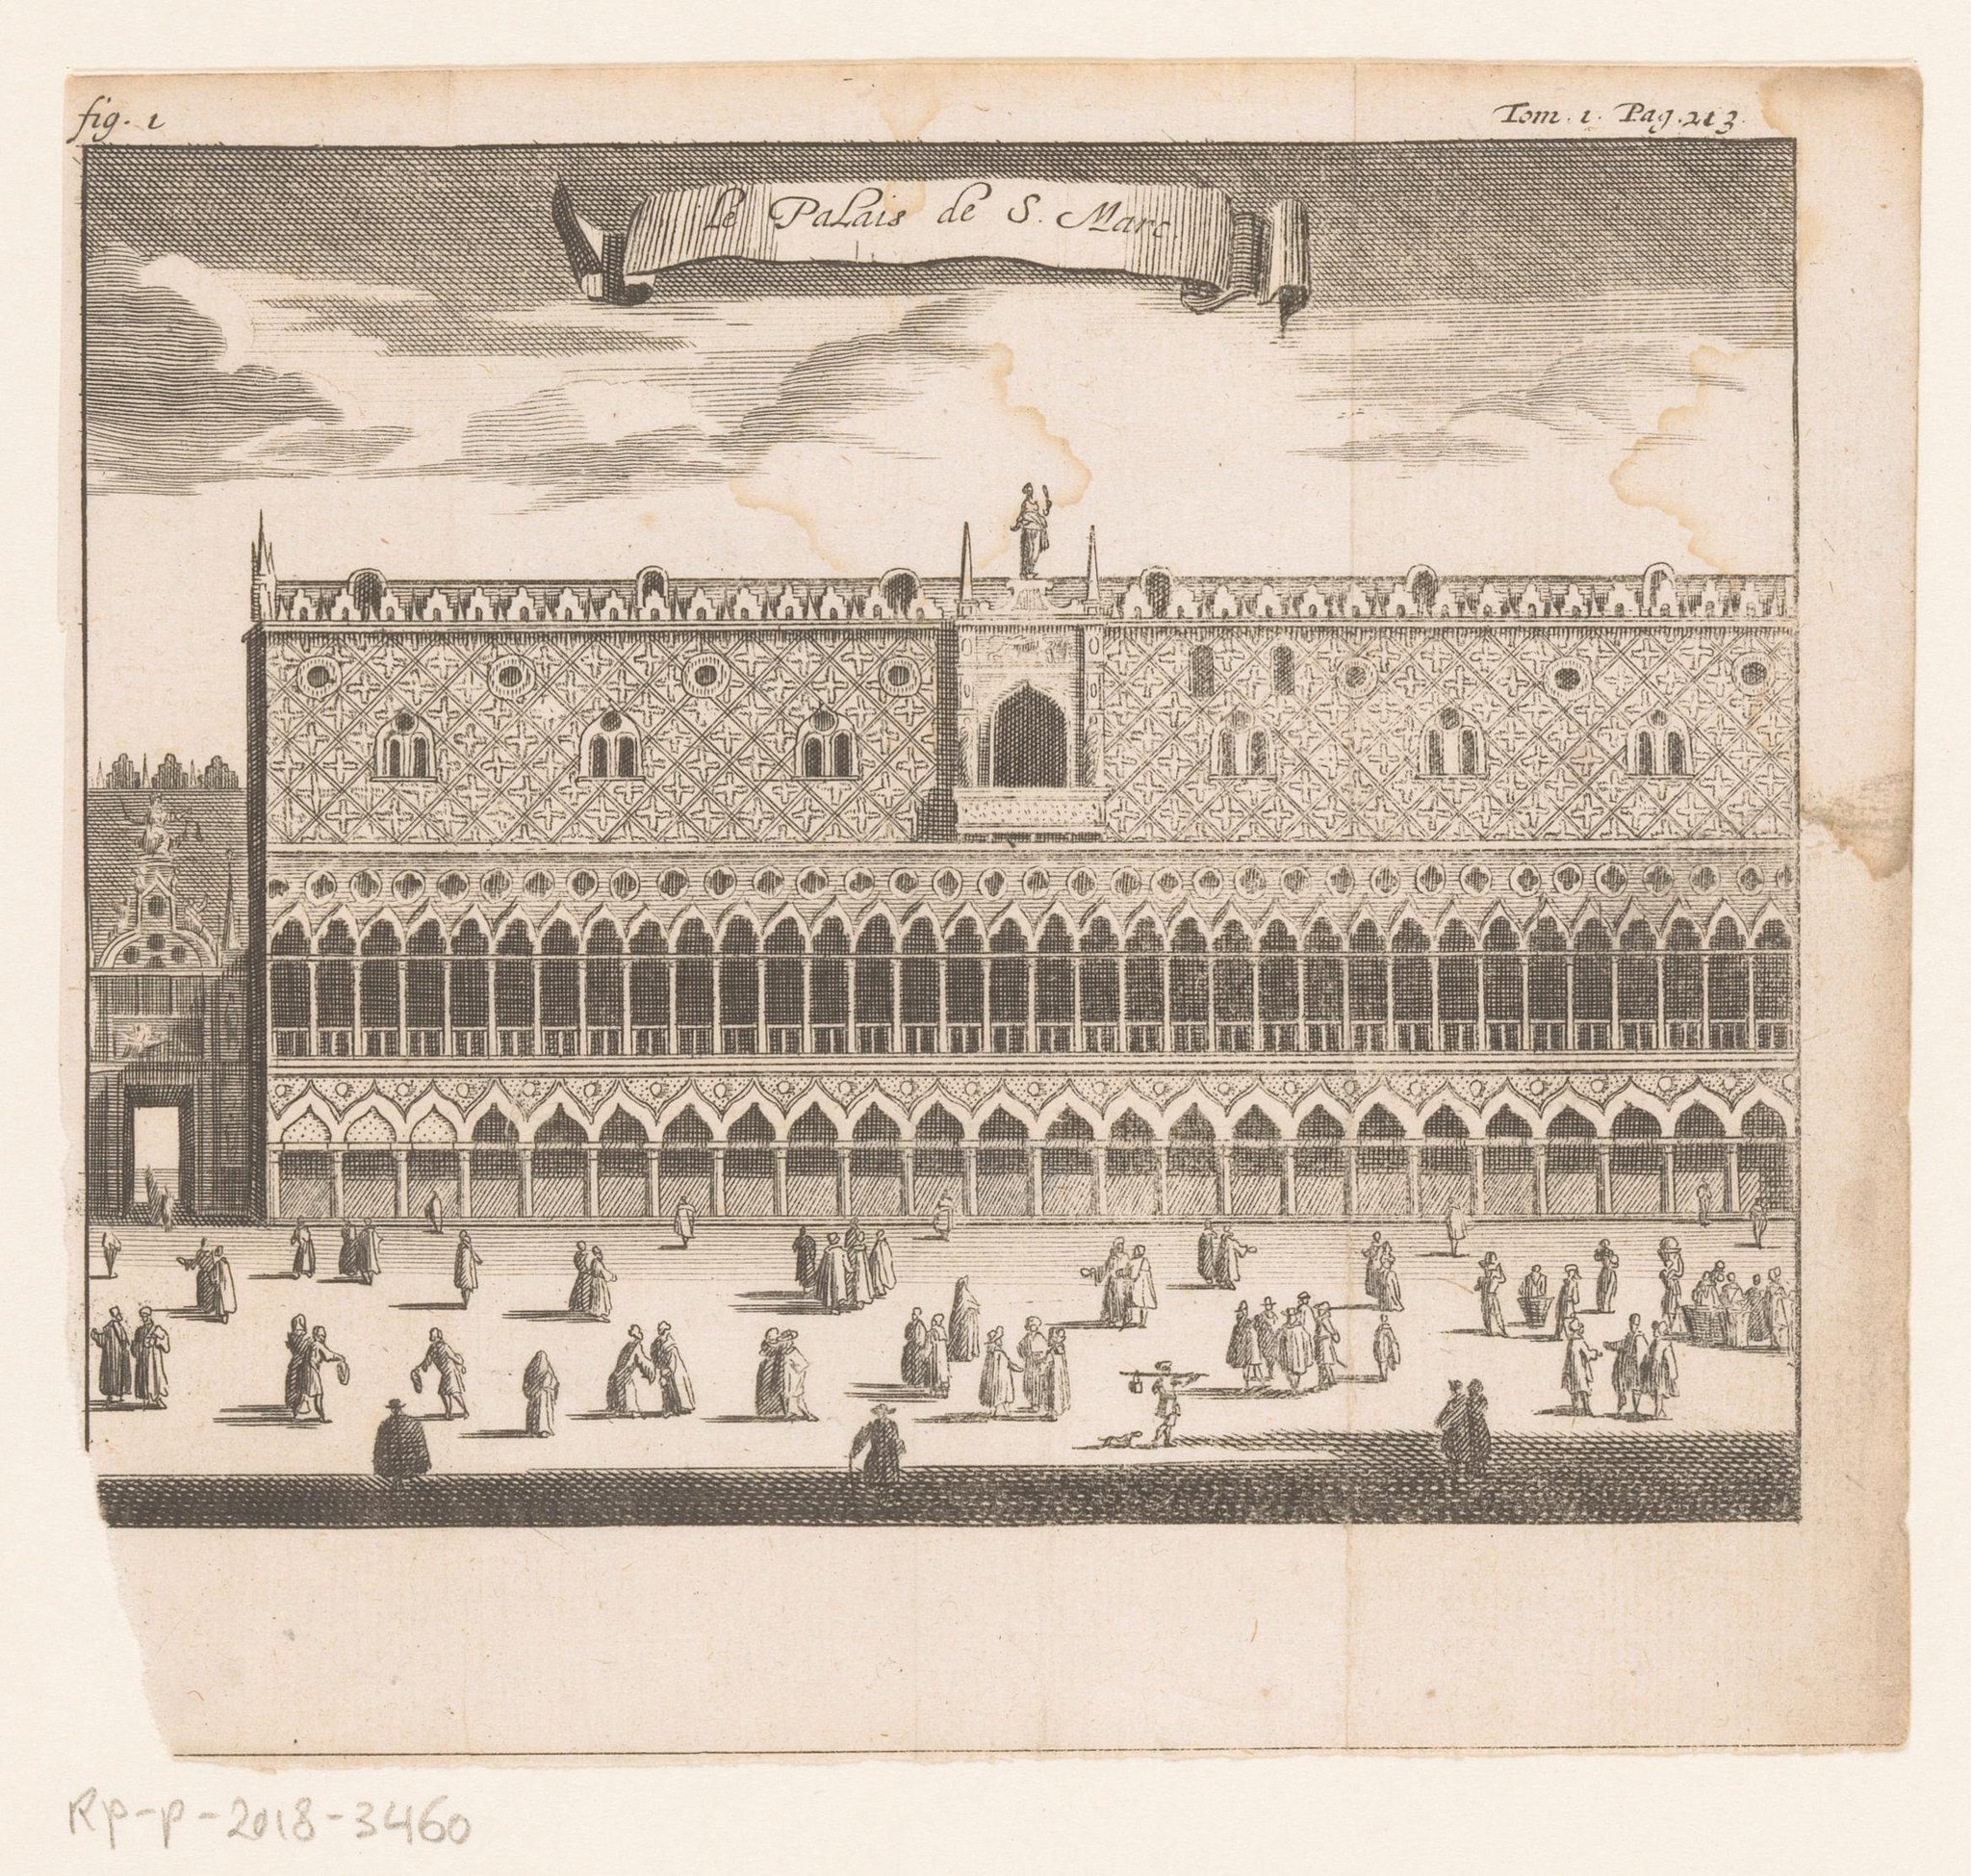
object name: print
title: Le Palais de S Marc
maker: Anonymous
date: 1670-1750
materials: paper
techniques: etching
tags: palace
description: Linksboven: fig. 1. Rechtsboven: tom. 1, pag. 193.